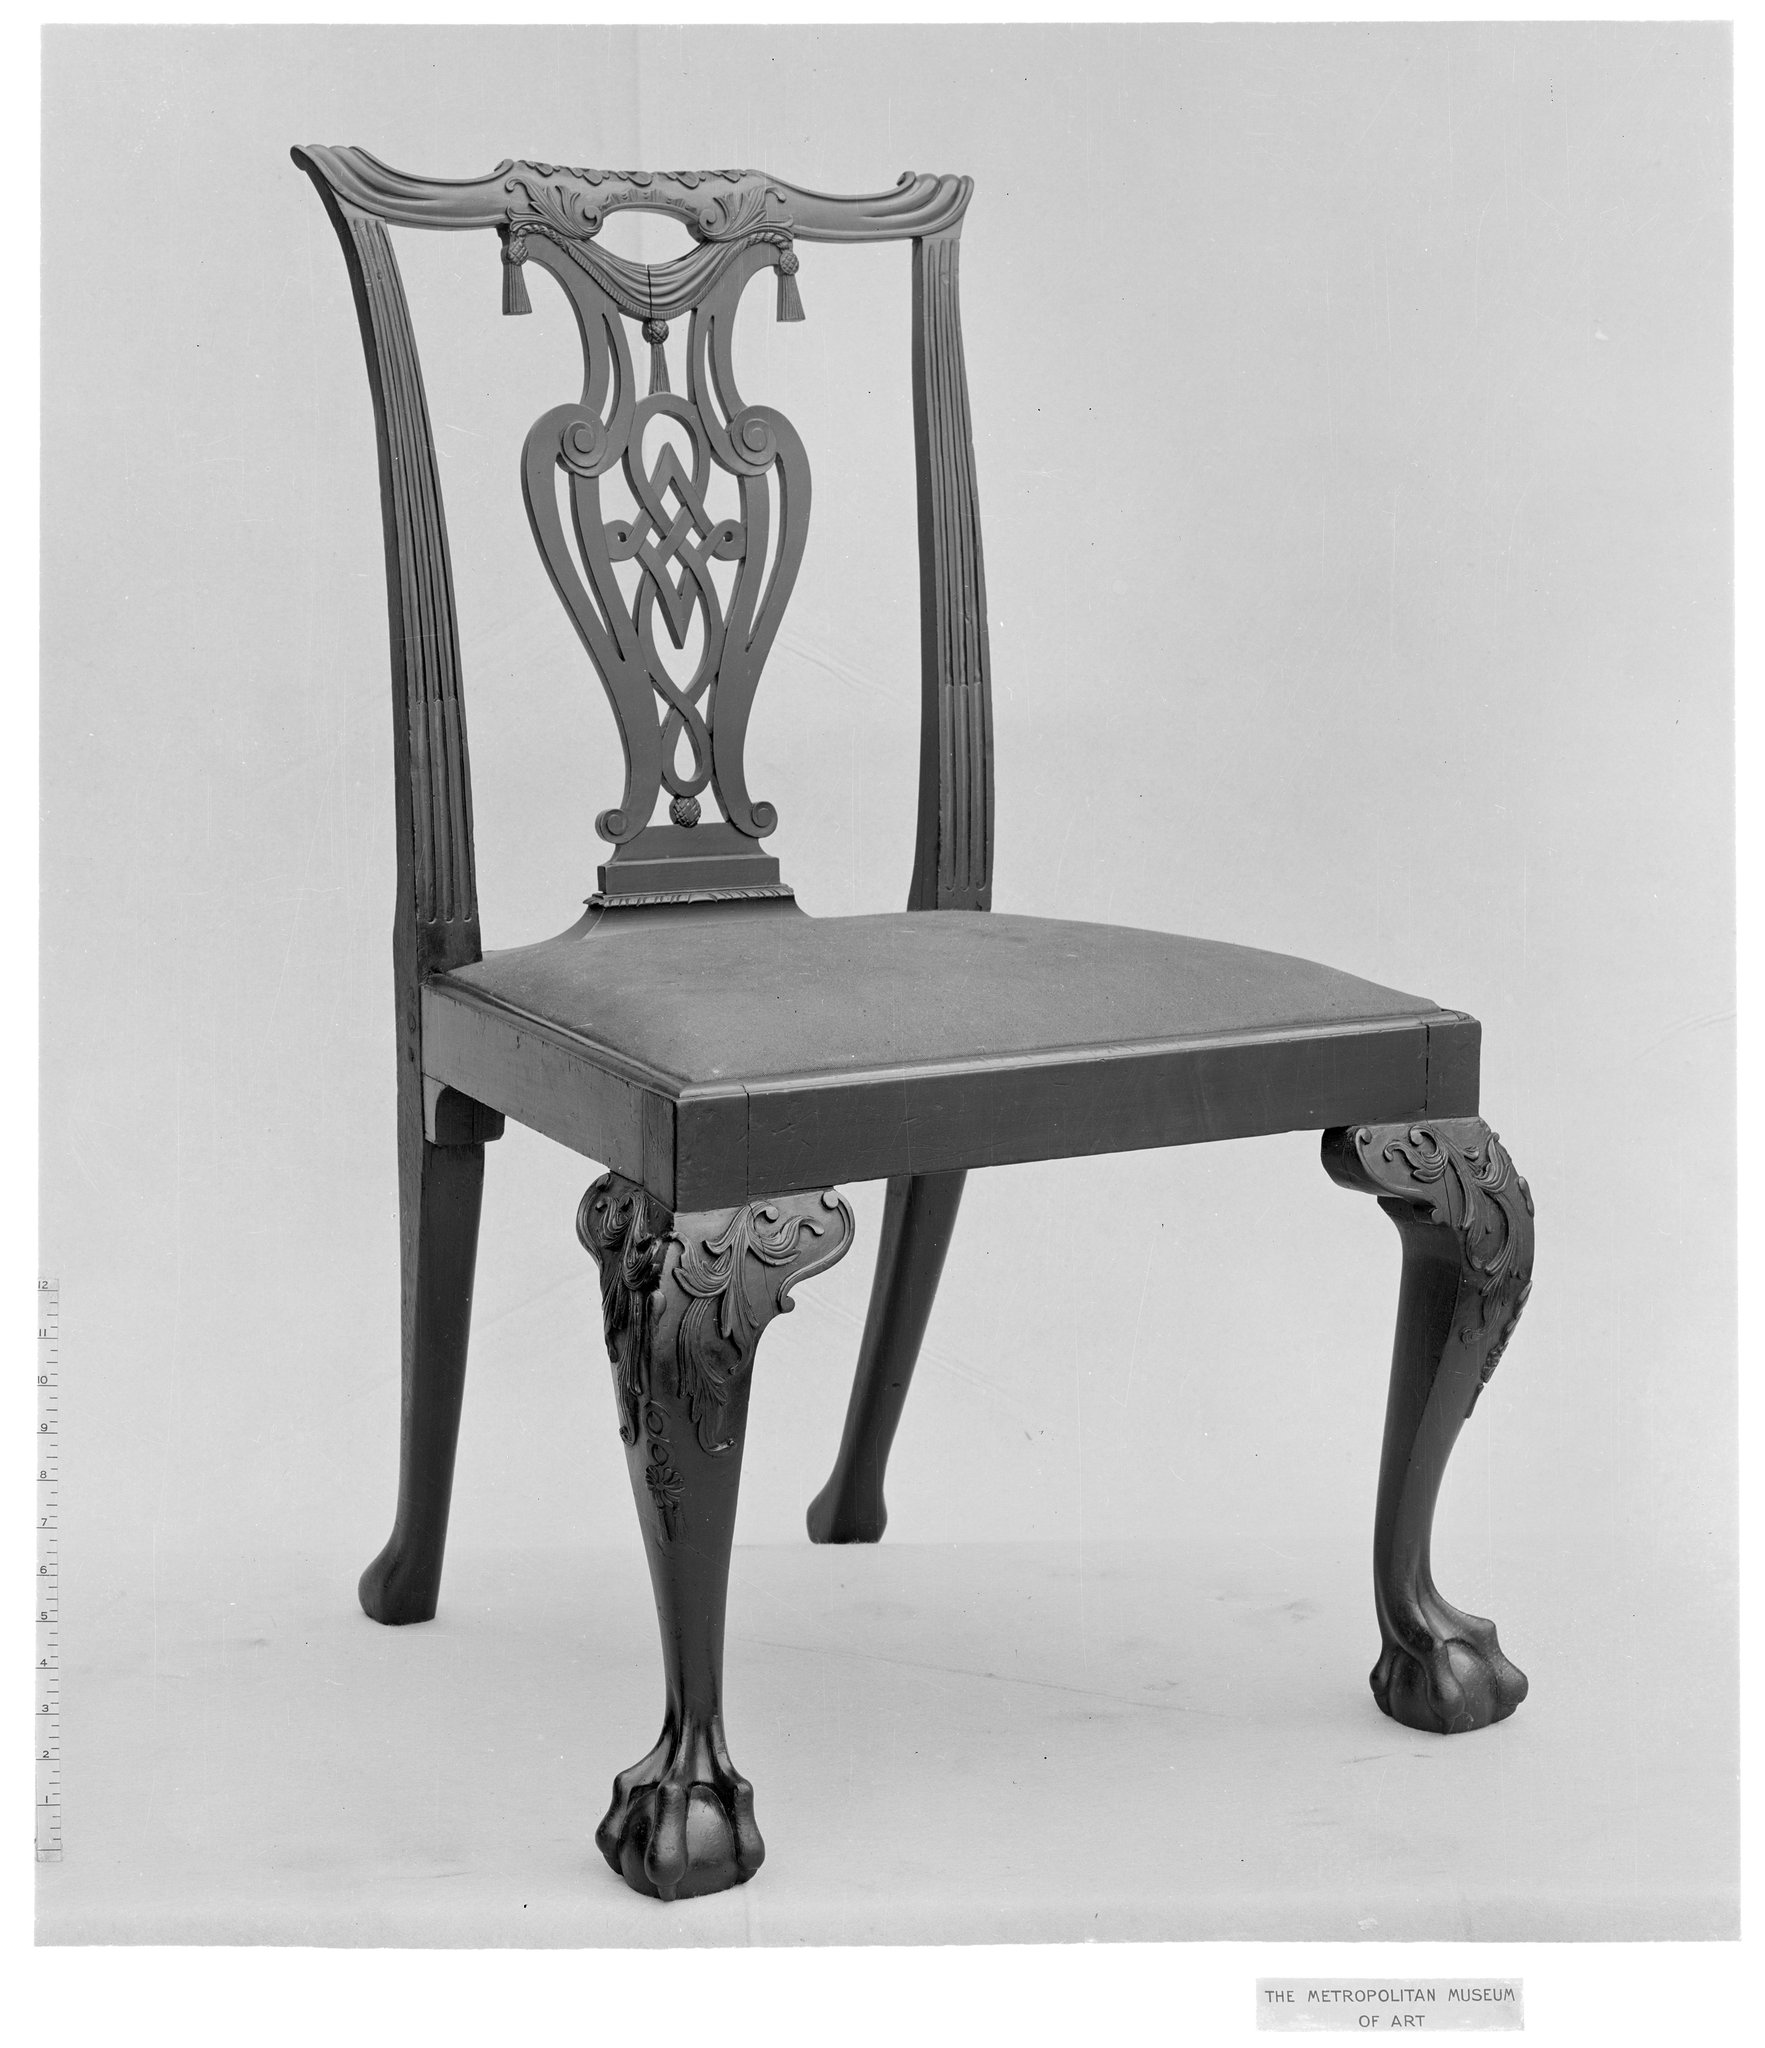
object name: chair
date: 1750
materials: wood